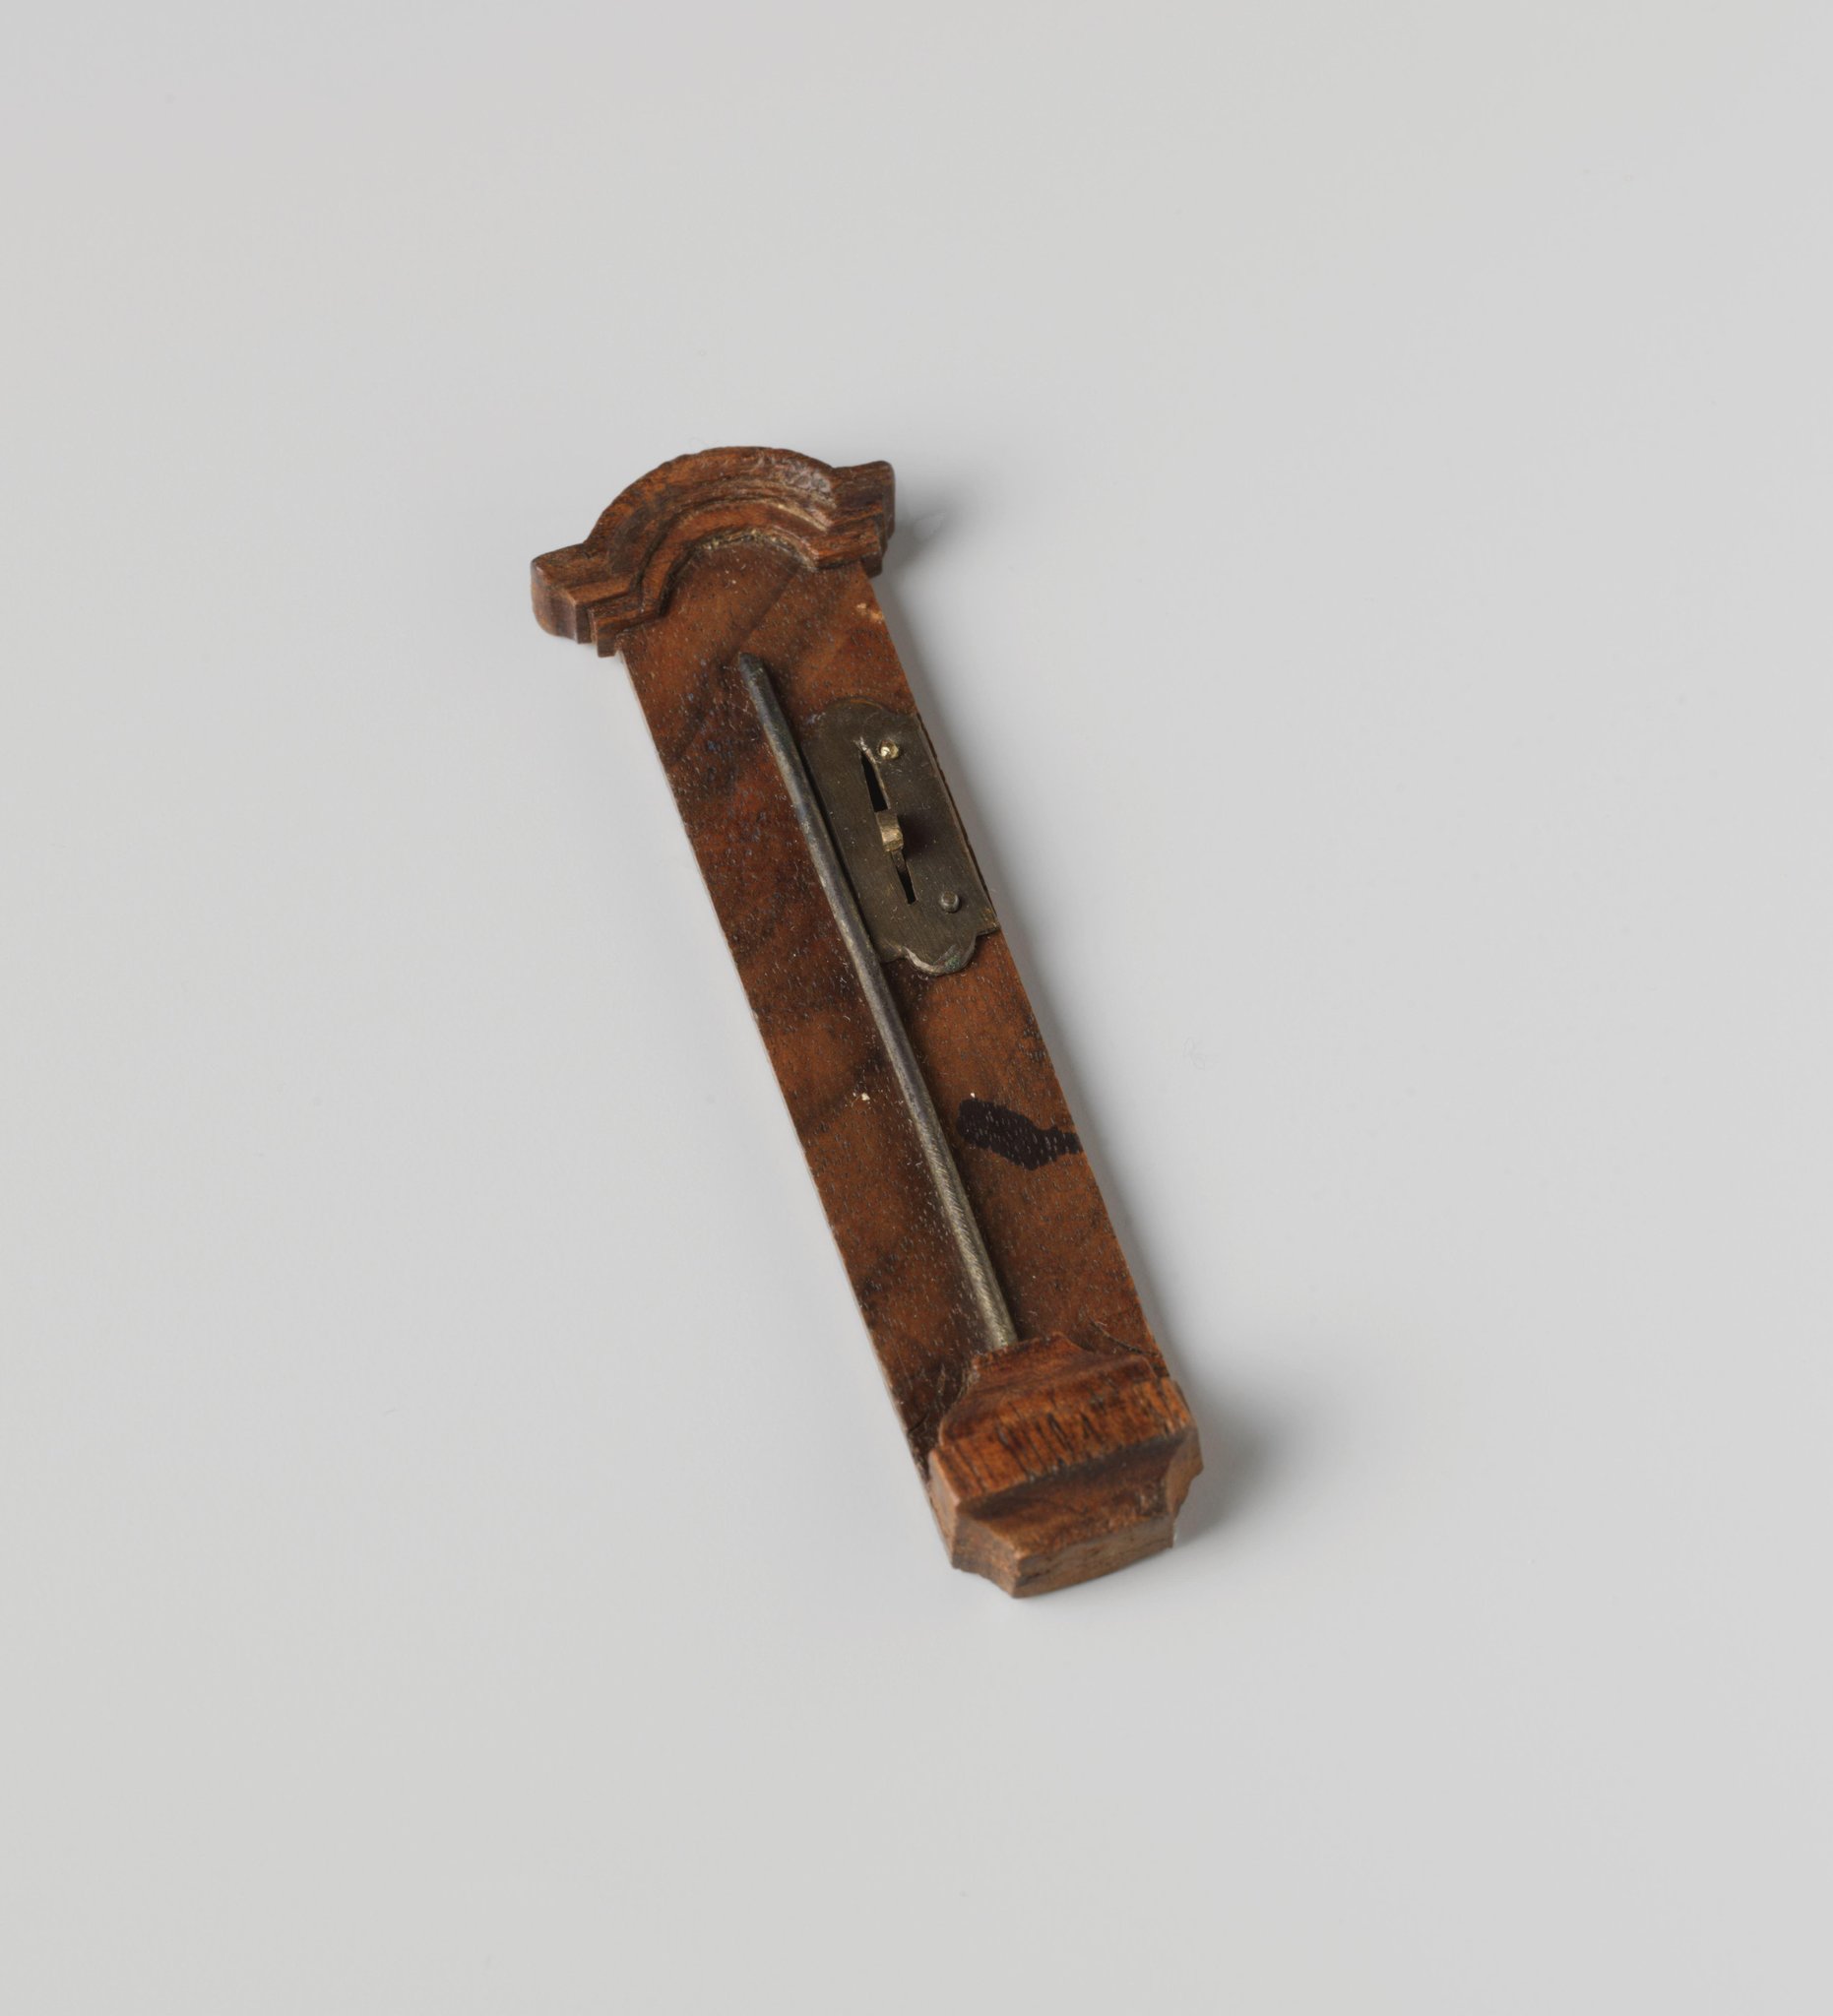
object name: miniature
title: Barometer in een langwerpige kast met gebogen kap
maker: Anonymous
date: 1740-1760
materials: brass, wood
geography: amsterdam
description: Gladde, langwerpige wandbarometer van notenhout, met koperen staaf, rustend op een voetstuk, waarnaast een koperen plaat. De kast is bekroond met een gebogen, geprofileerde kap en kan opgehangen worden aan een touw.